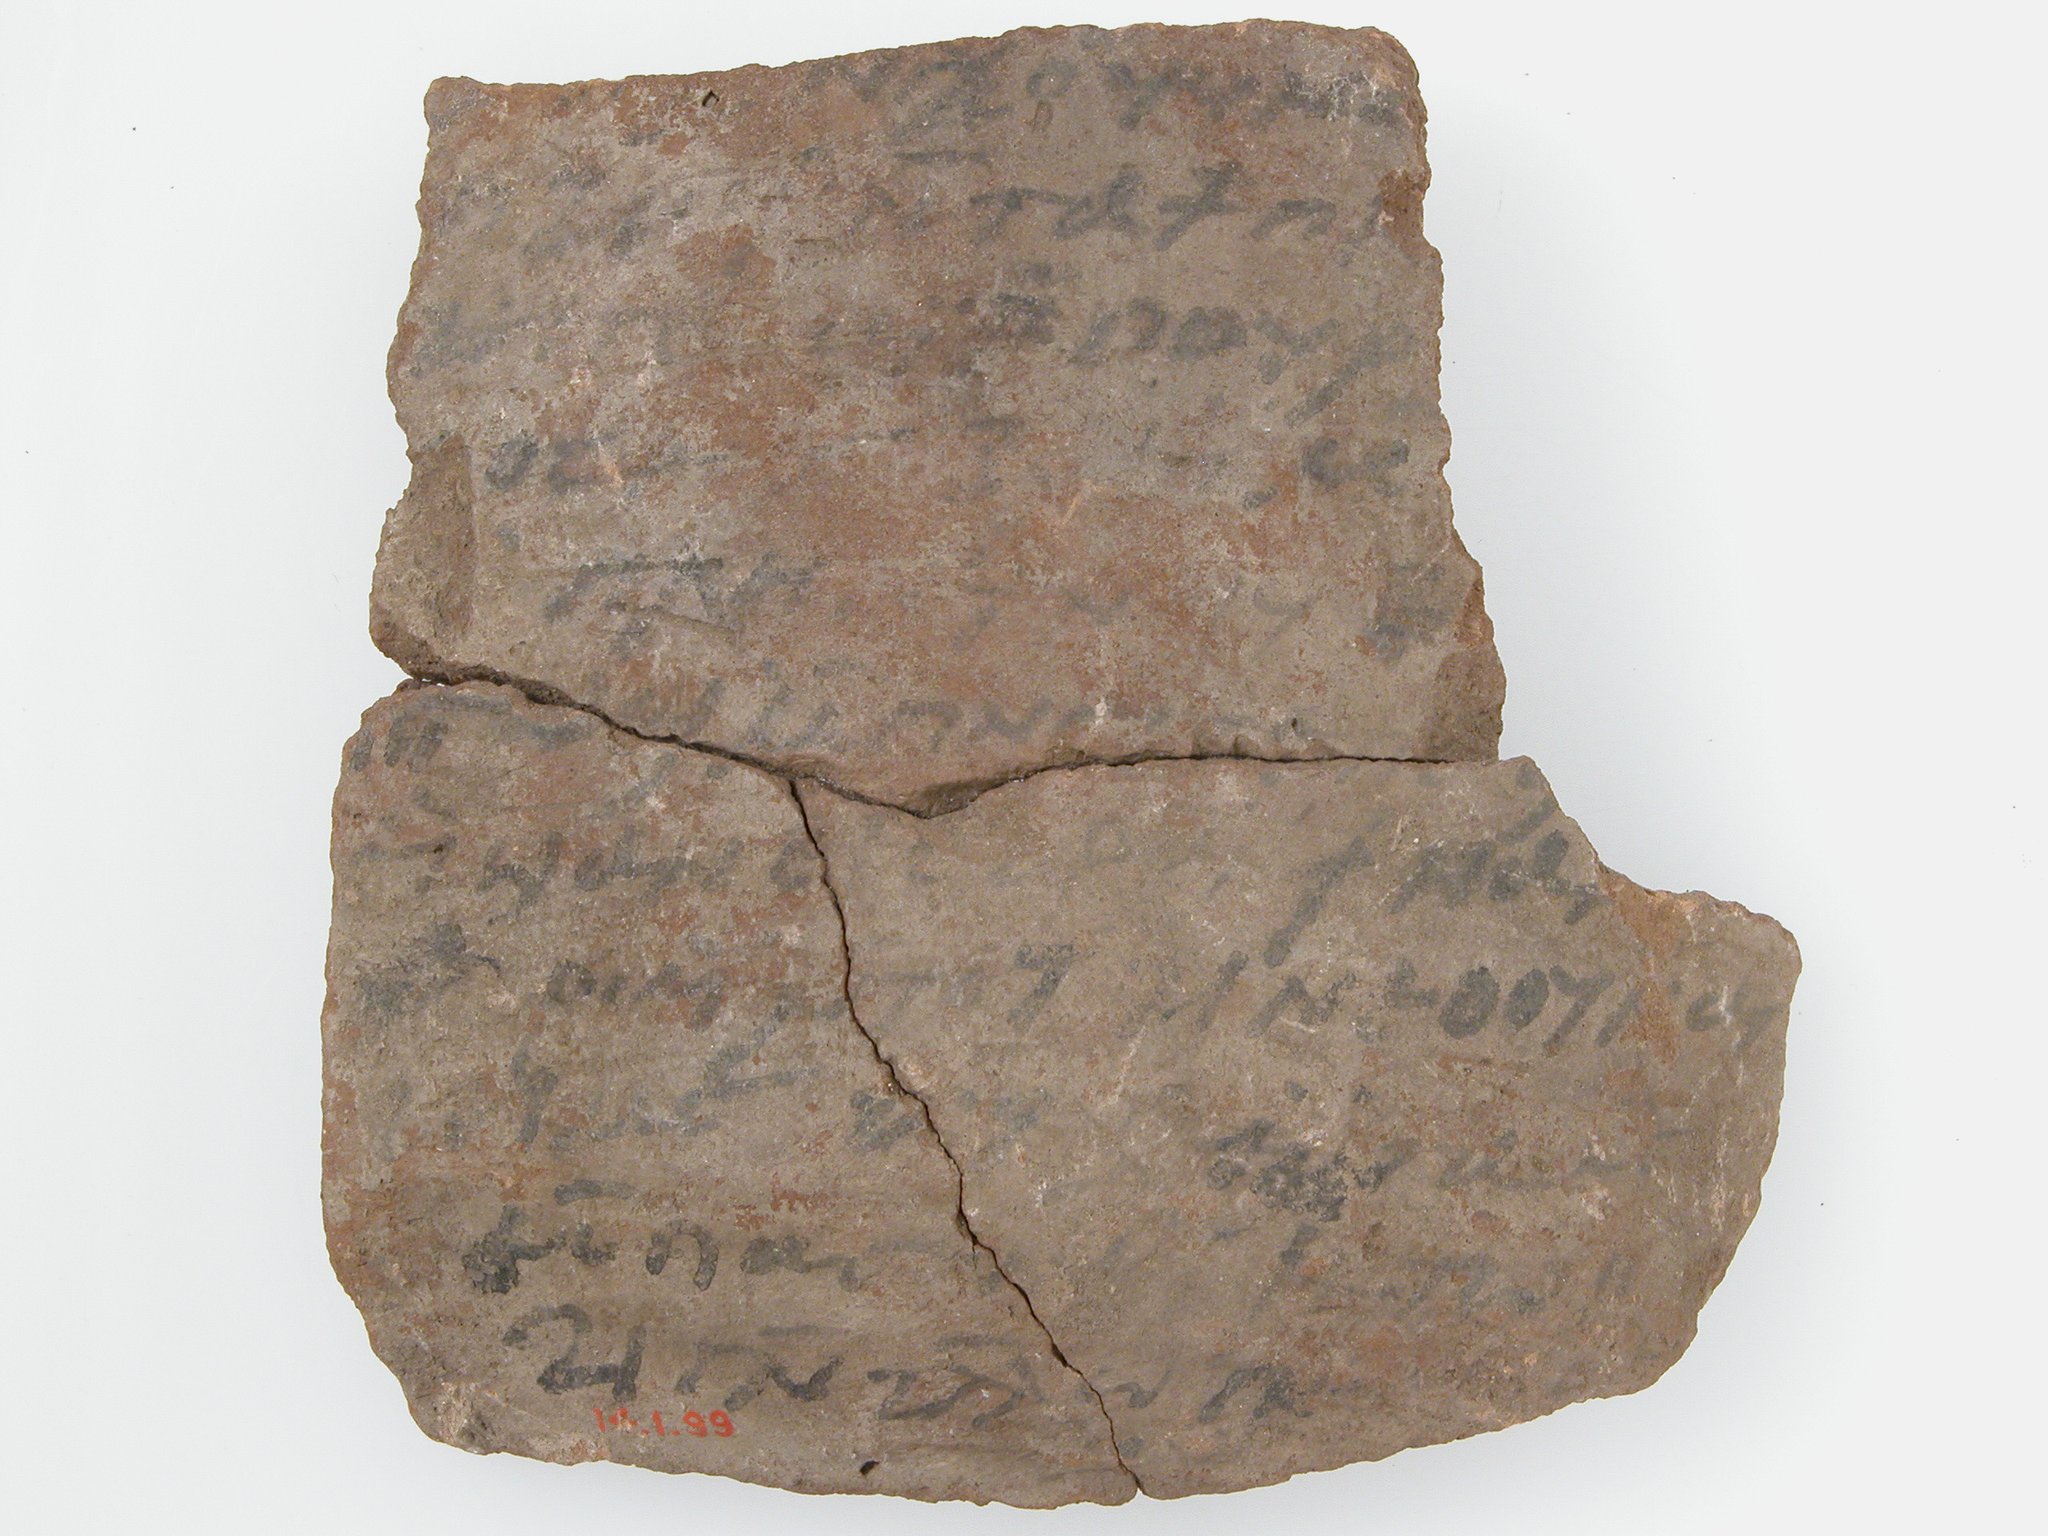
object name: ostrakon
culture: coptic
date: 600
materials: ink, pottery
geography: egypt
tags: coptic,documents